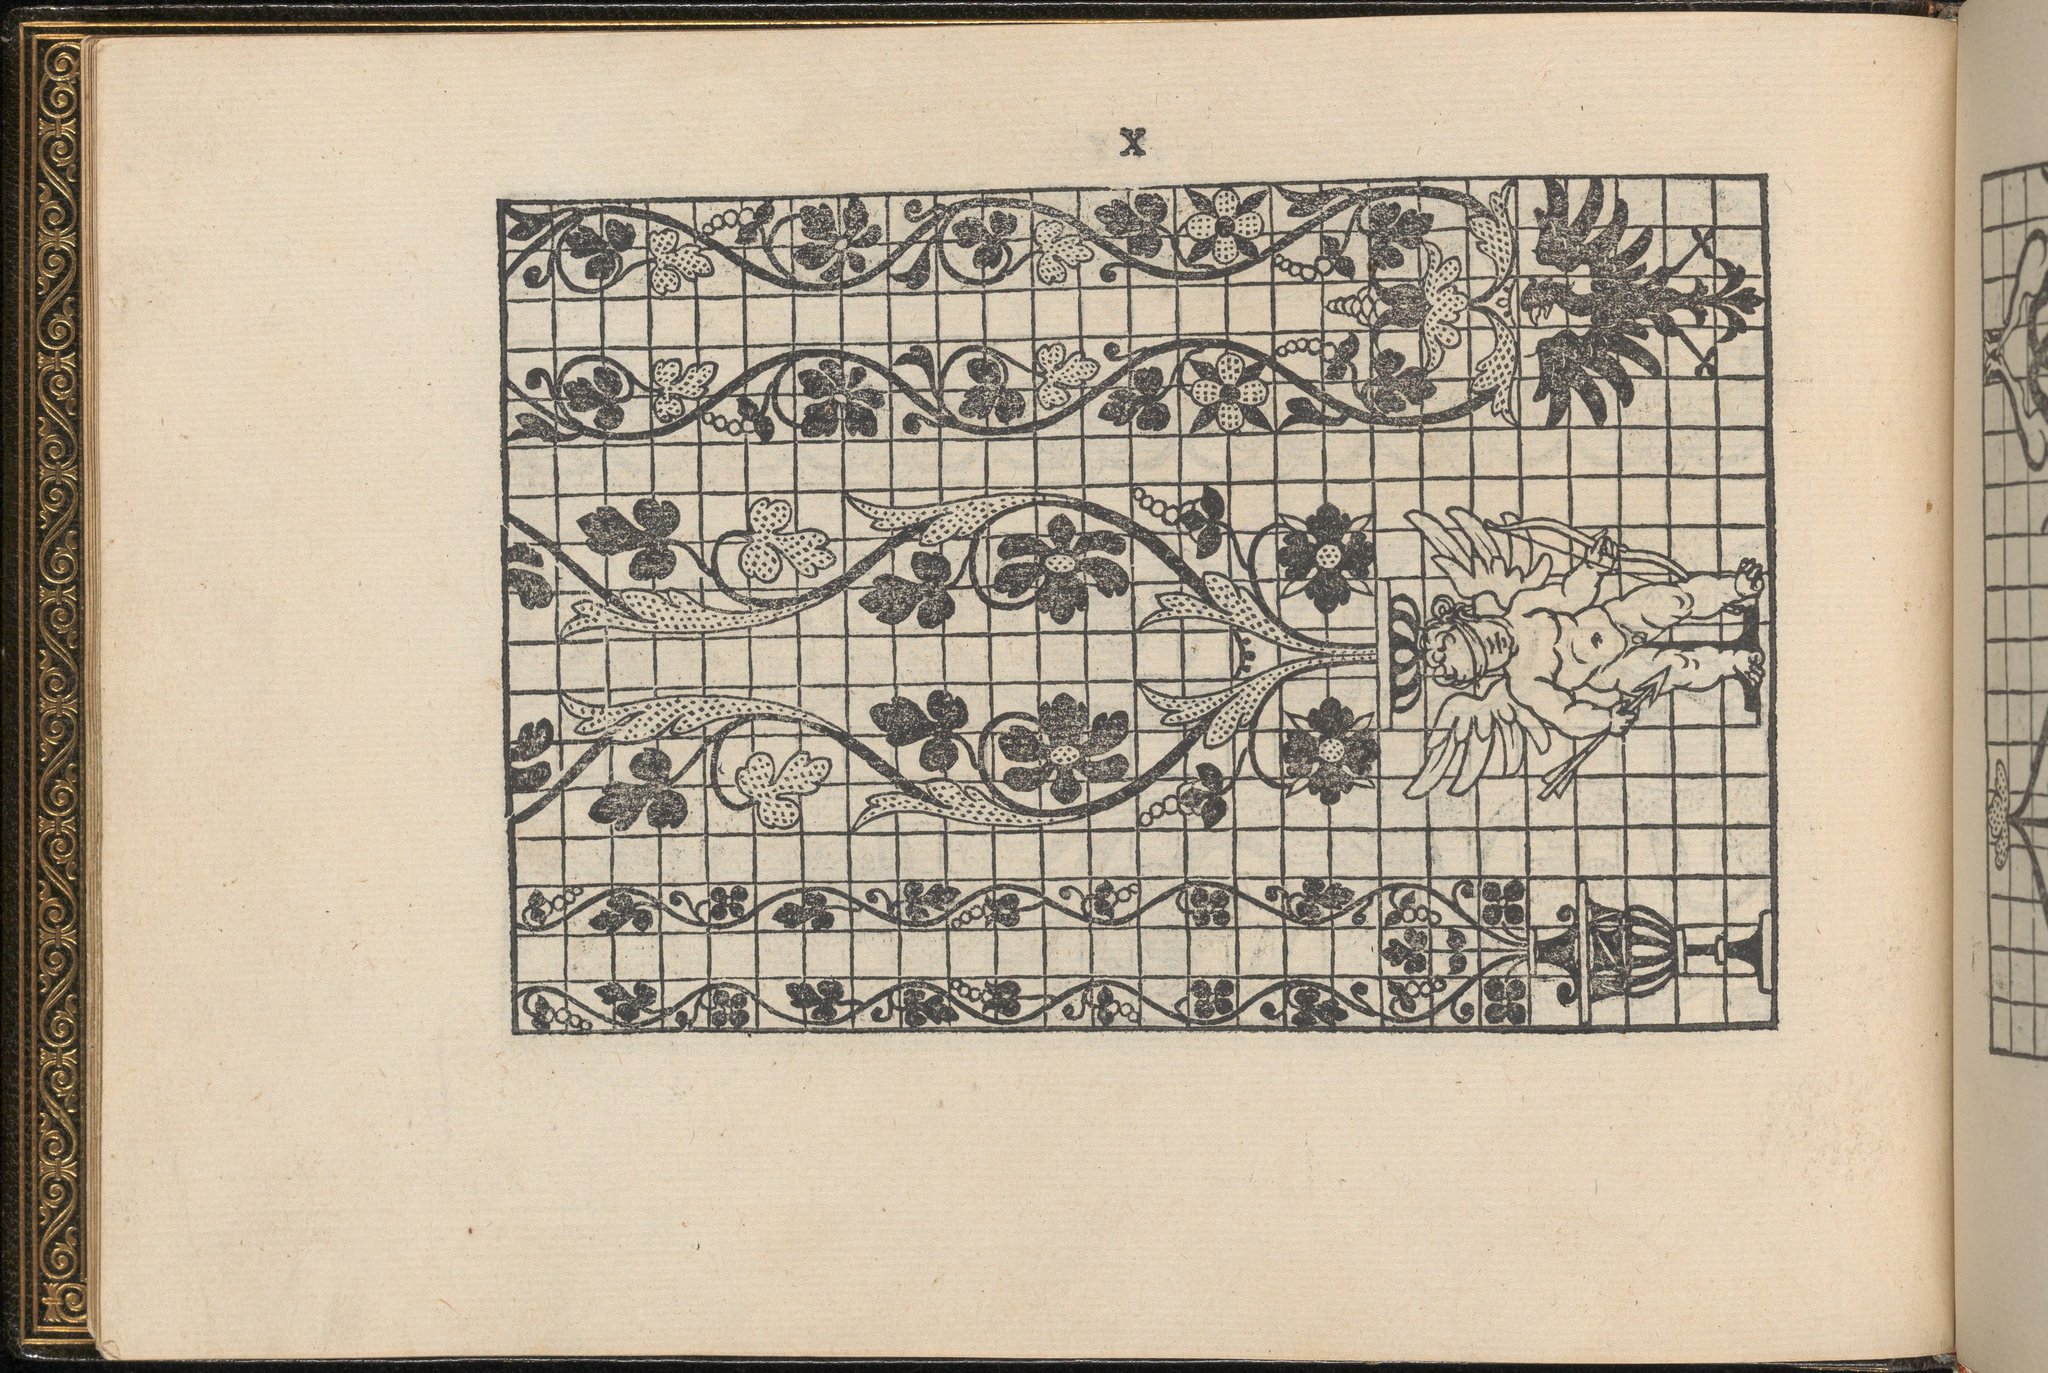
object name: book print ornament architecture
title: La Vera Perfettione del Disegno di varie sorti di recami, page 5 (verso)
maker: giovanni ostaus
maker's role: publisher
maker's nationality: italian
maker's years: 1507-1607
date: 1567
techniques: woodcut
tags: birds,ornament,cupid,flowers